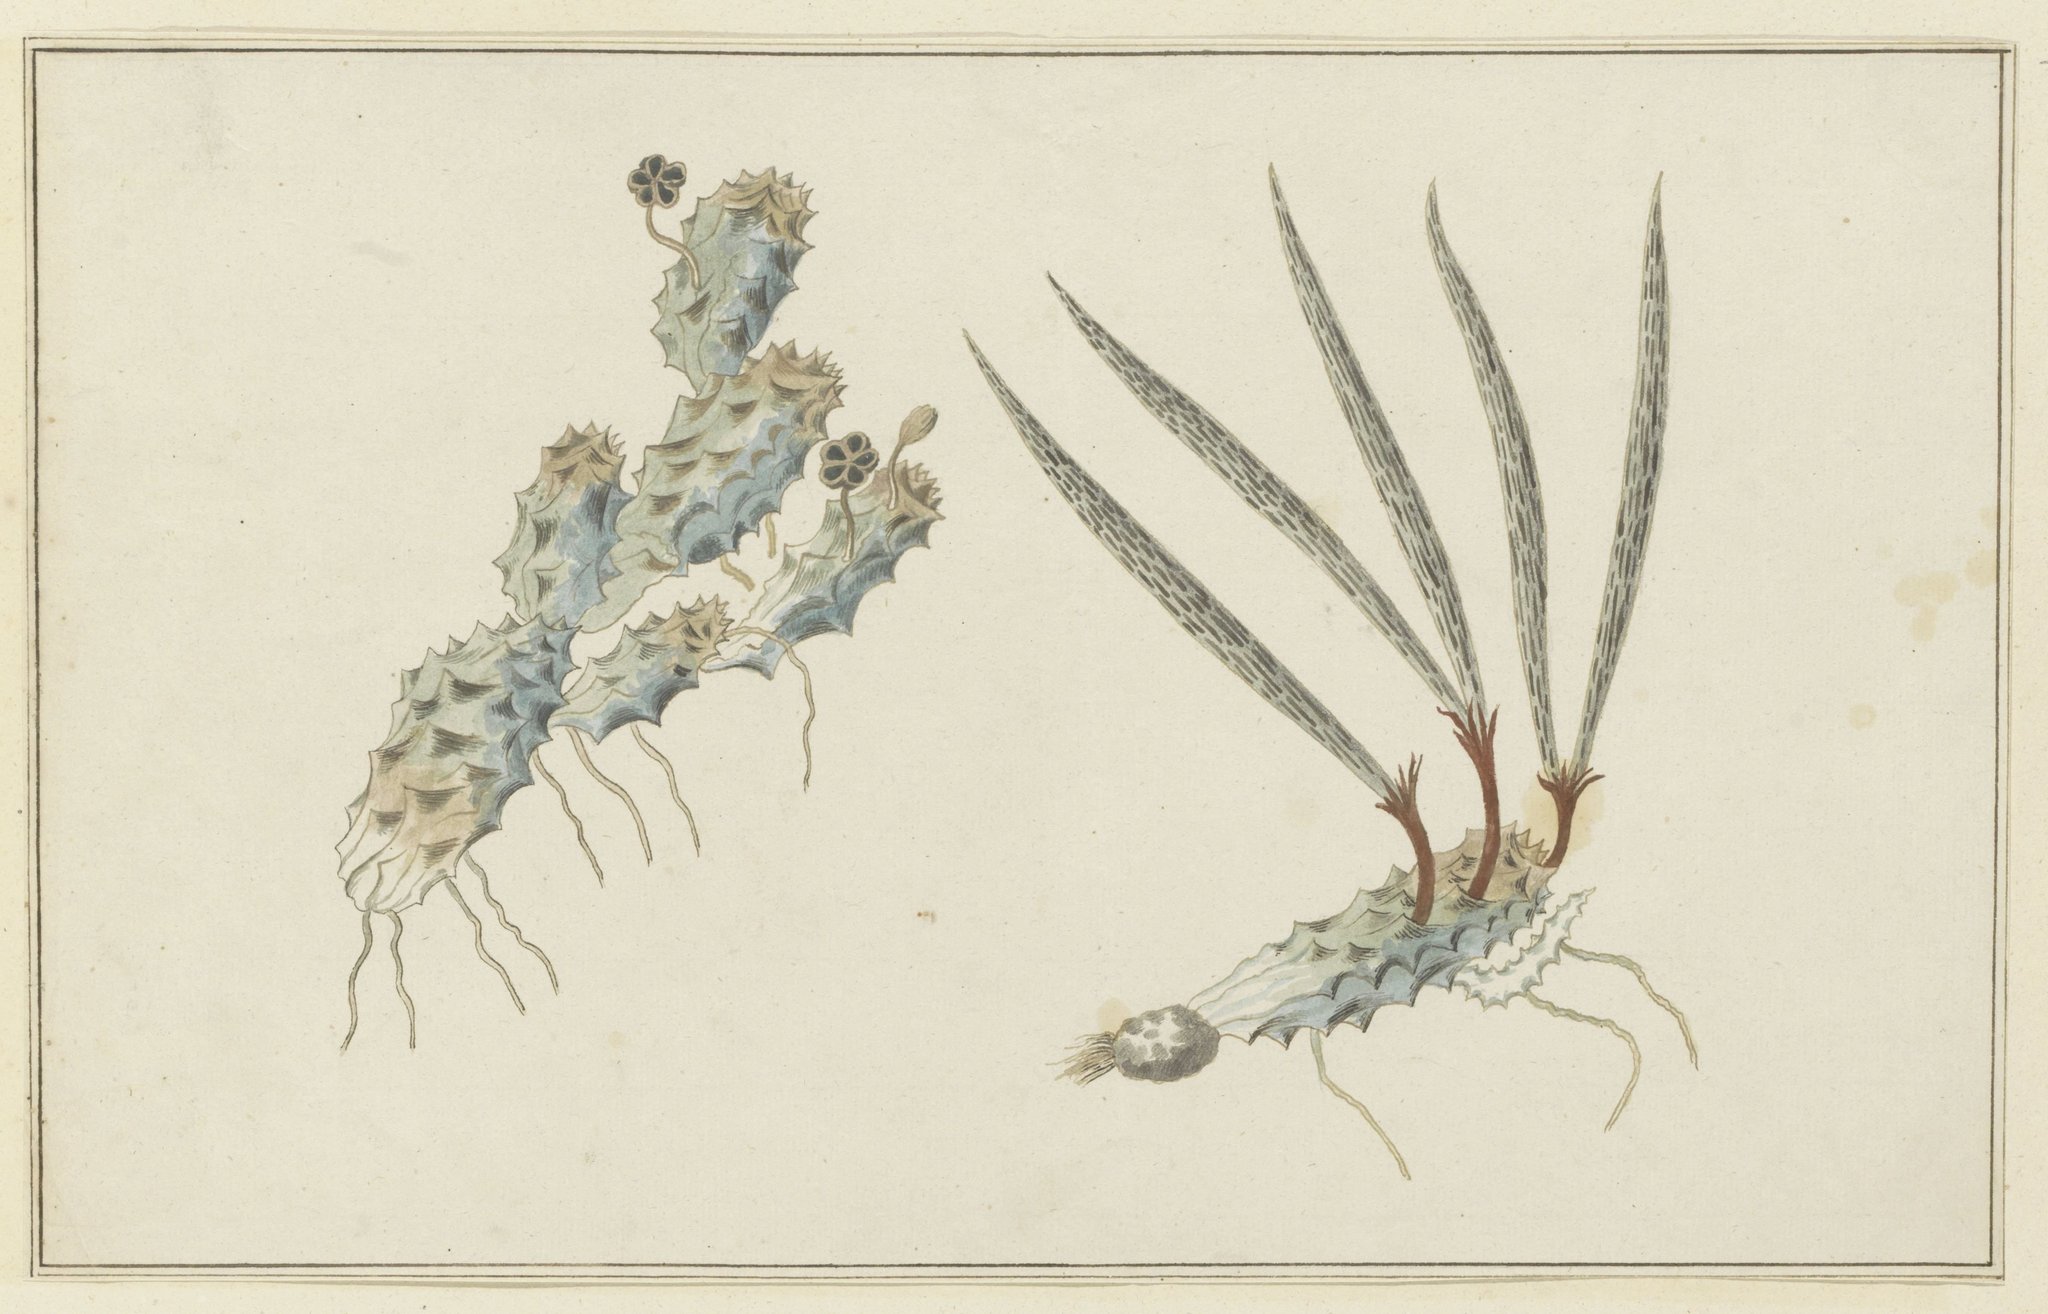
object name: album leaf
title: Pectinaria articulata (Ait.) (Stapelia nigrum)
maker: robert jacob gordon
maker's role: draughtsman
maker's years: 1743-1795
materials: chalk, ink, paper, pencil, watercolor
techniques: brush, pen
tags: plants; vegetation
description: De tekening is gemaakt voor of tijdens een van Gordon's vier expedities door de Kaapprovincie, van oktober 1777 tot maart 1786. Sommige (soort)namen kunnen zijn gewijzigd, gezien reorganisatie in plantentaxonomie gedurende de afgelopen jaren.